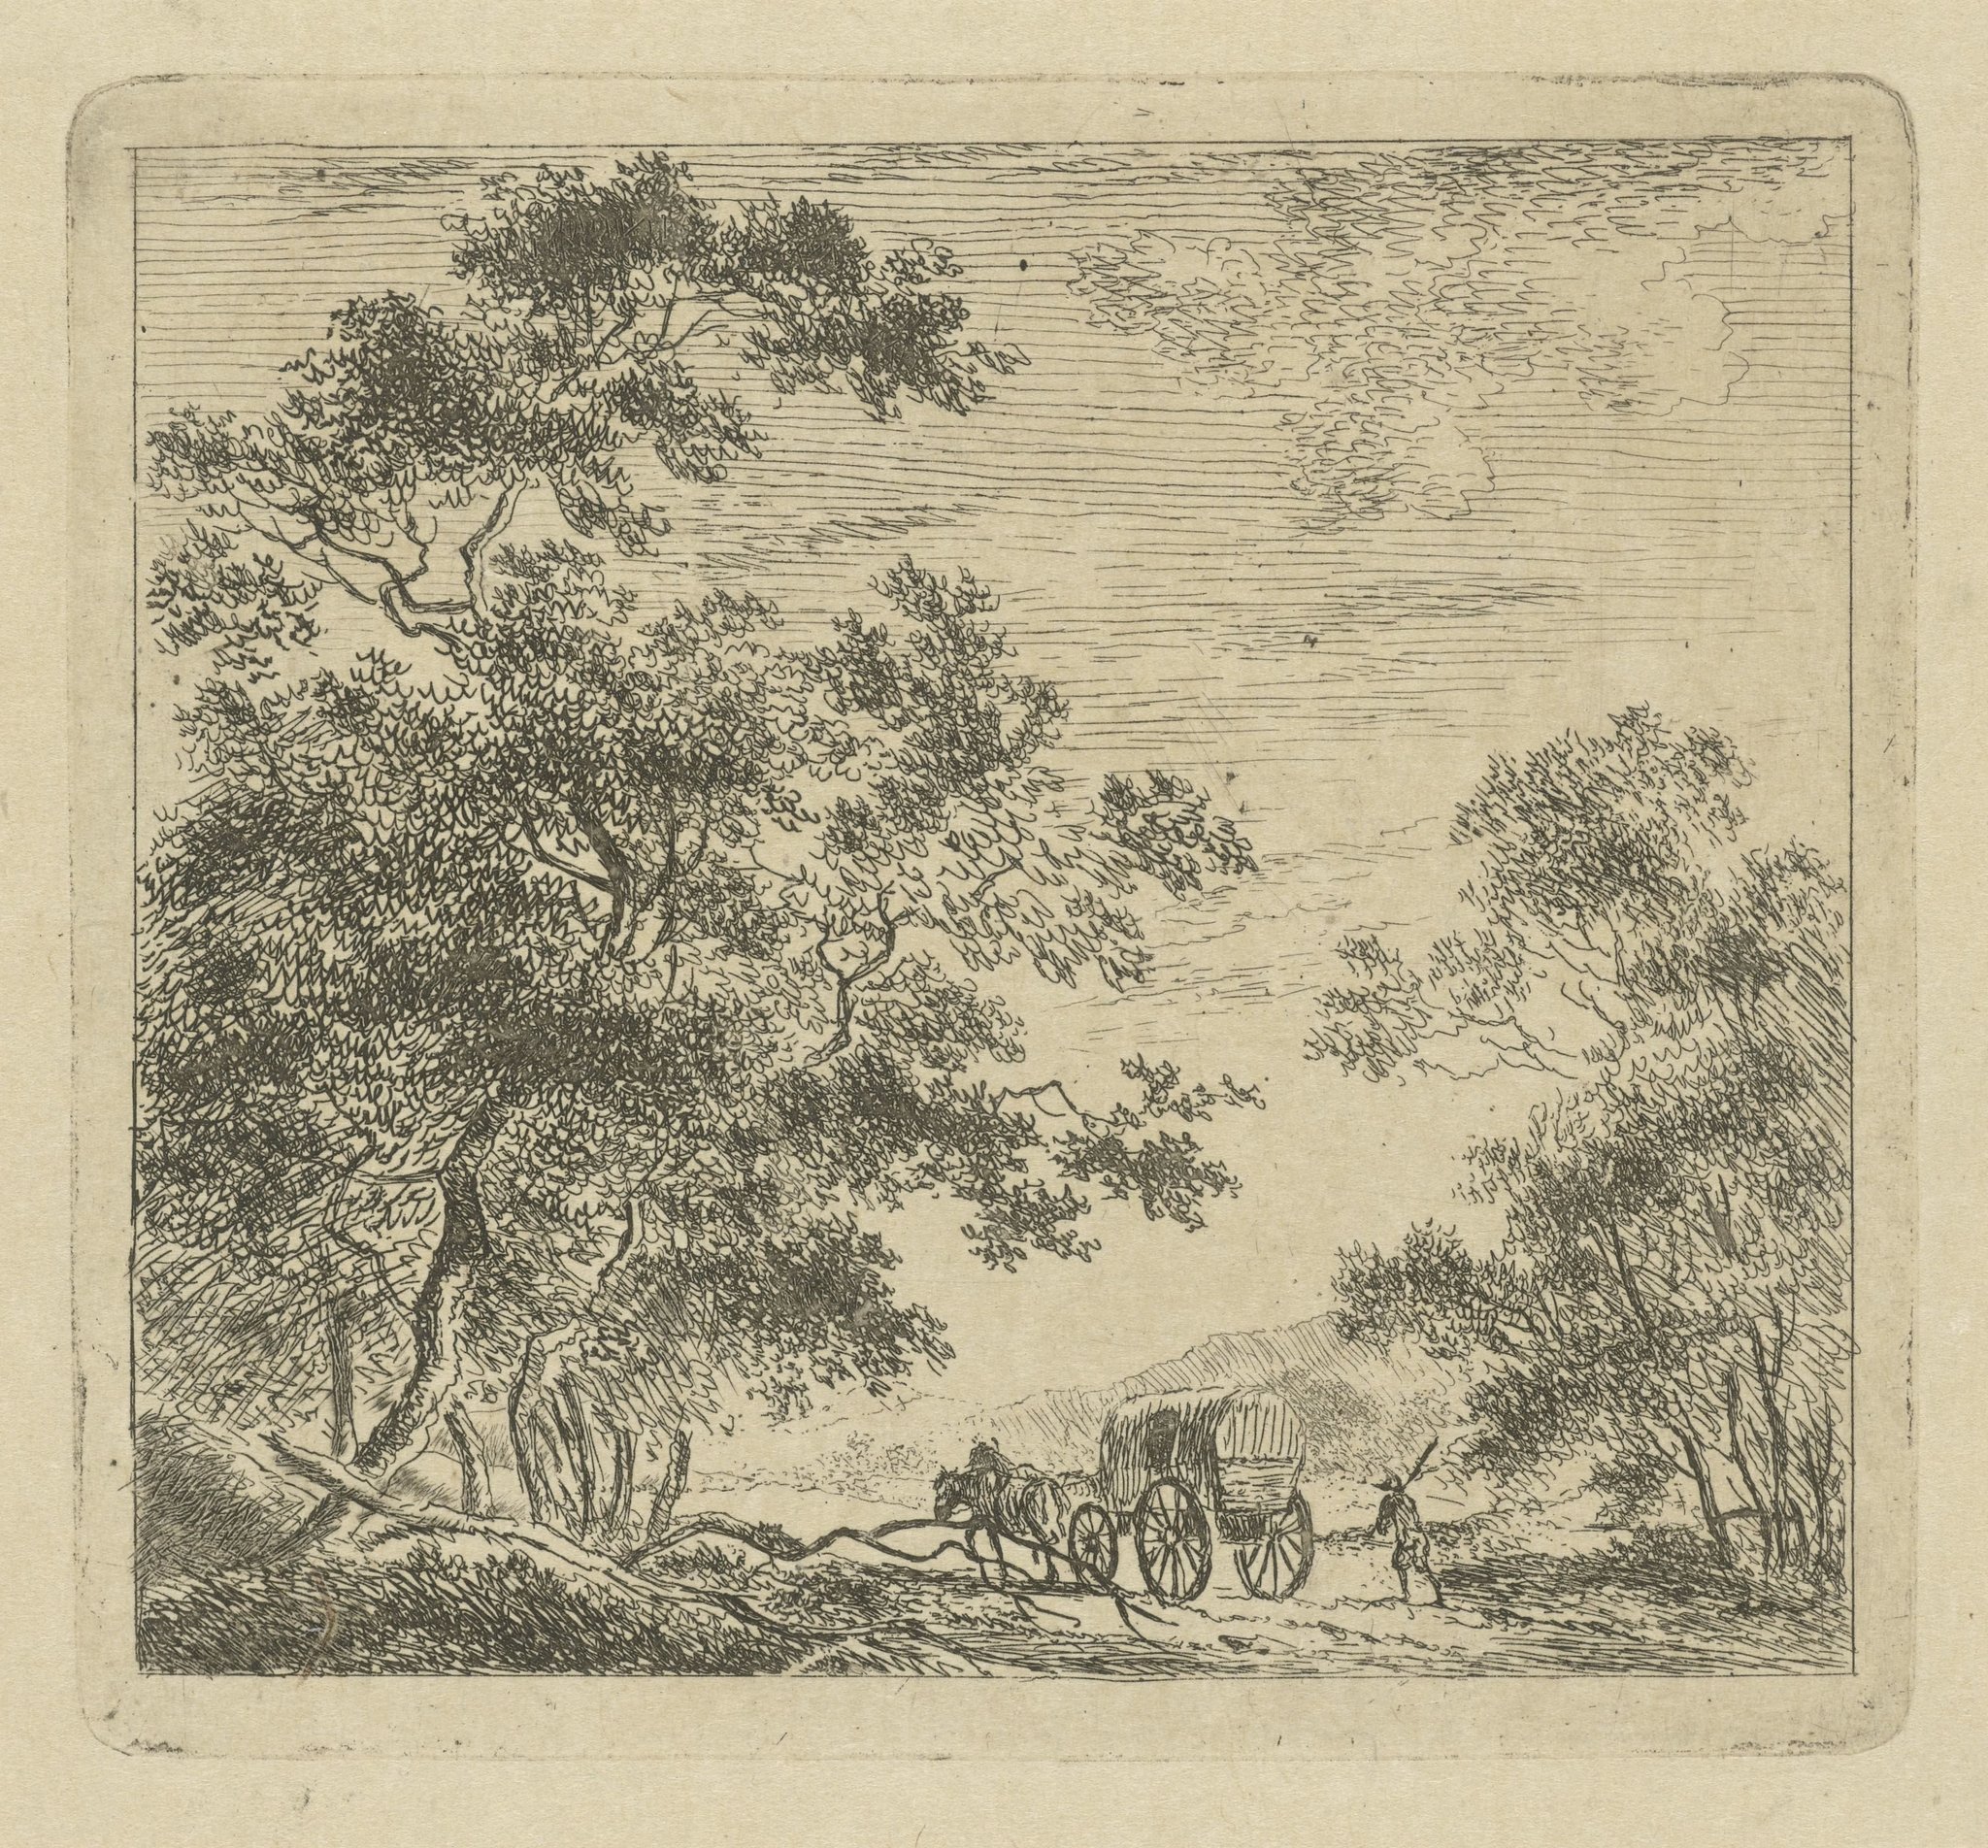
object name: print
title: Landschap met postwagen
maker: johannes janson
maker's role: draughtsman, painter, print maker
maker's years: 1729-1784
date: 1761-1784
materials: paper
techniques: etching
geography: leiden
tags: postal service, landscapes (+ landscape with figures, staffage)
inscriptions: collector's mark: Lugt 240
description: Bosweg met postwagen en een lopende figuur, op de rug gezien. Mét de lucht.